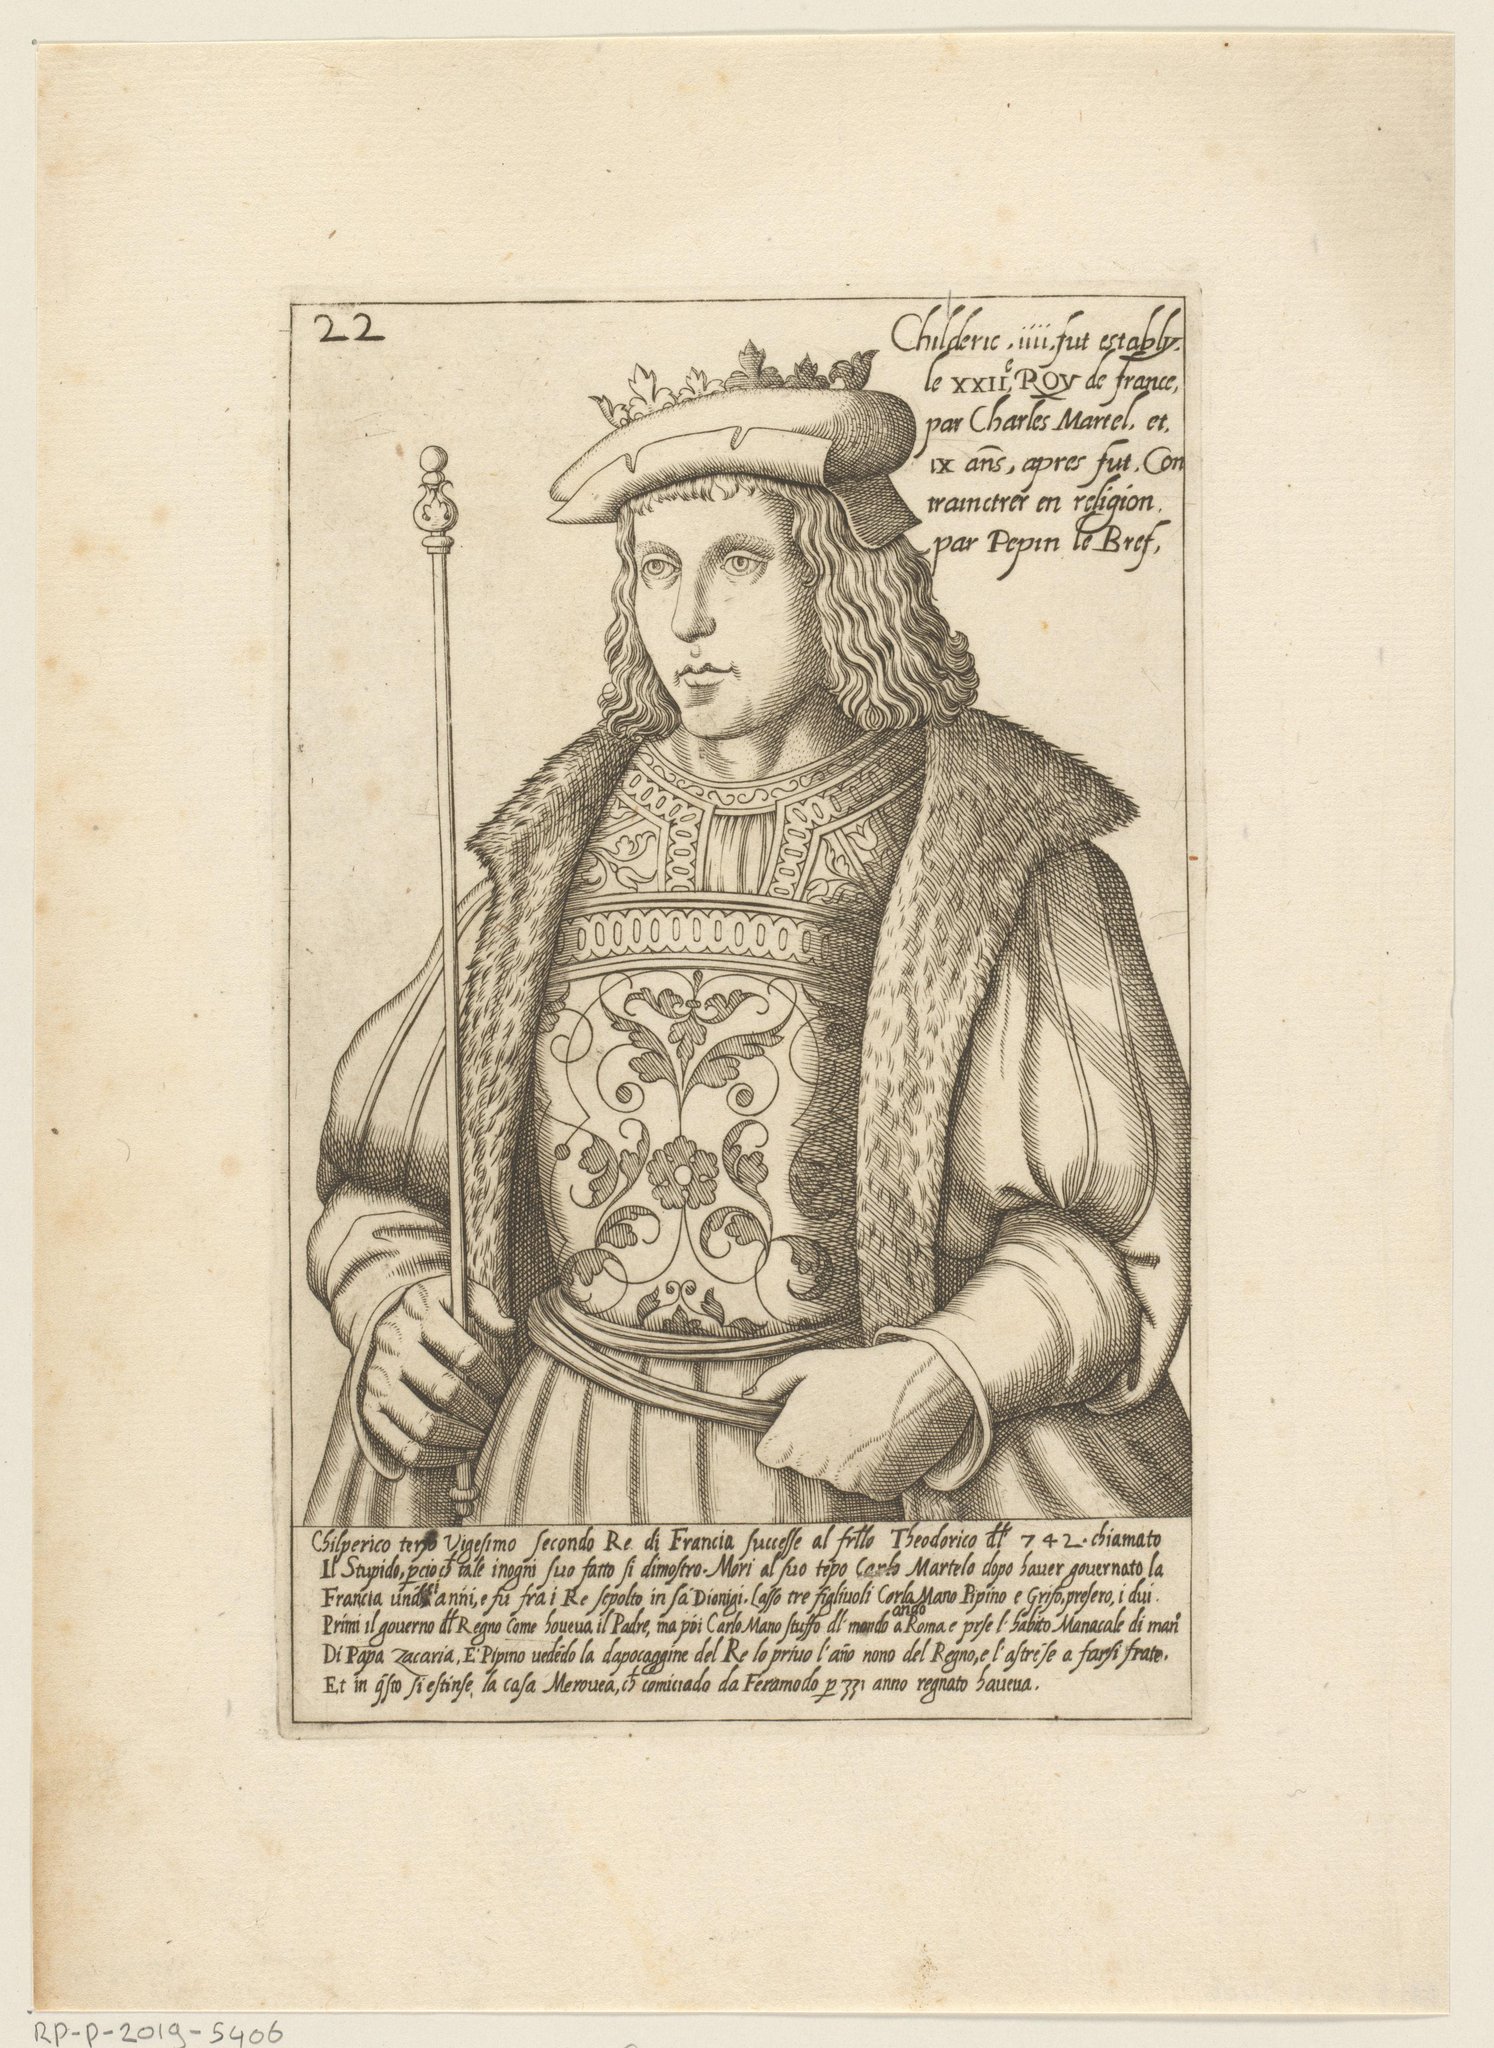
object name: book illustration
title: Portret van Childerik III, koning der Franken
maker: Anonymous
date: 1588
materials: paper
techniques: engraving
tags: sceptre, staff (symbol of sovereignty), historical persons, king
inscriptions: watermark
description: Prent voor het eerst gebruikt in: Cronica Breve de i fatti illustri de're di Francia, con le loro effigie dal naturale cominciando da Faramondo (...). Venetië: Bernardo Giunti, 1588. Prent in ieder geval ook gebruikt in de editie van 1590 en mogelijk ook in een Franse uitgave van 1597.